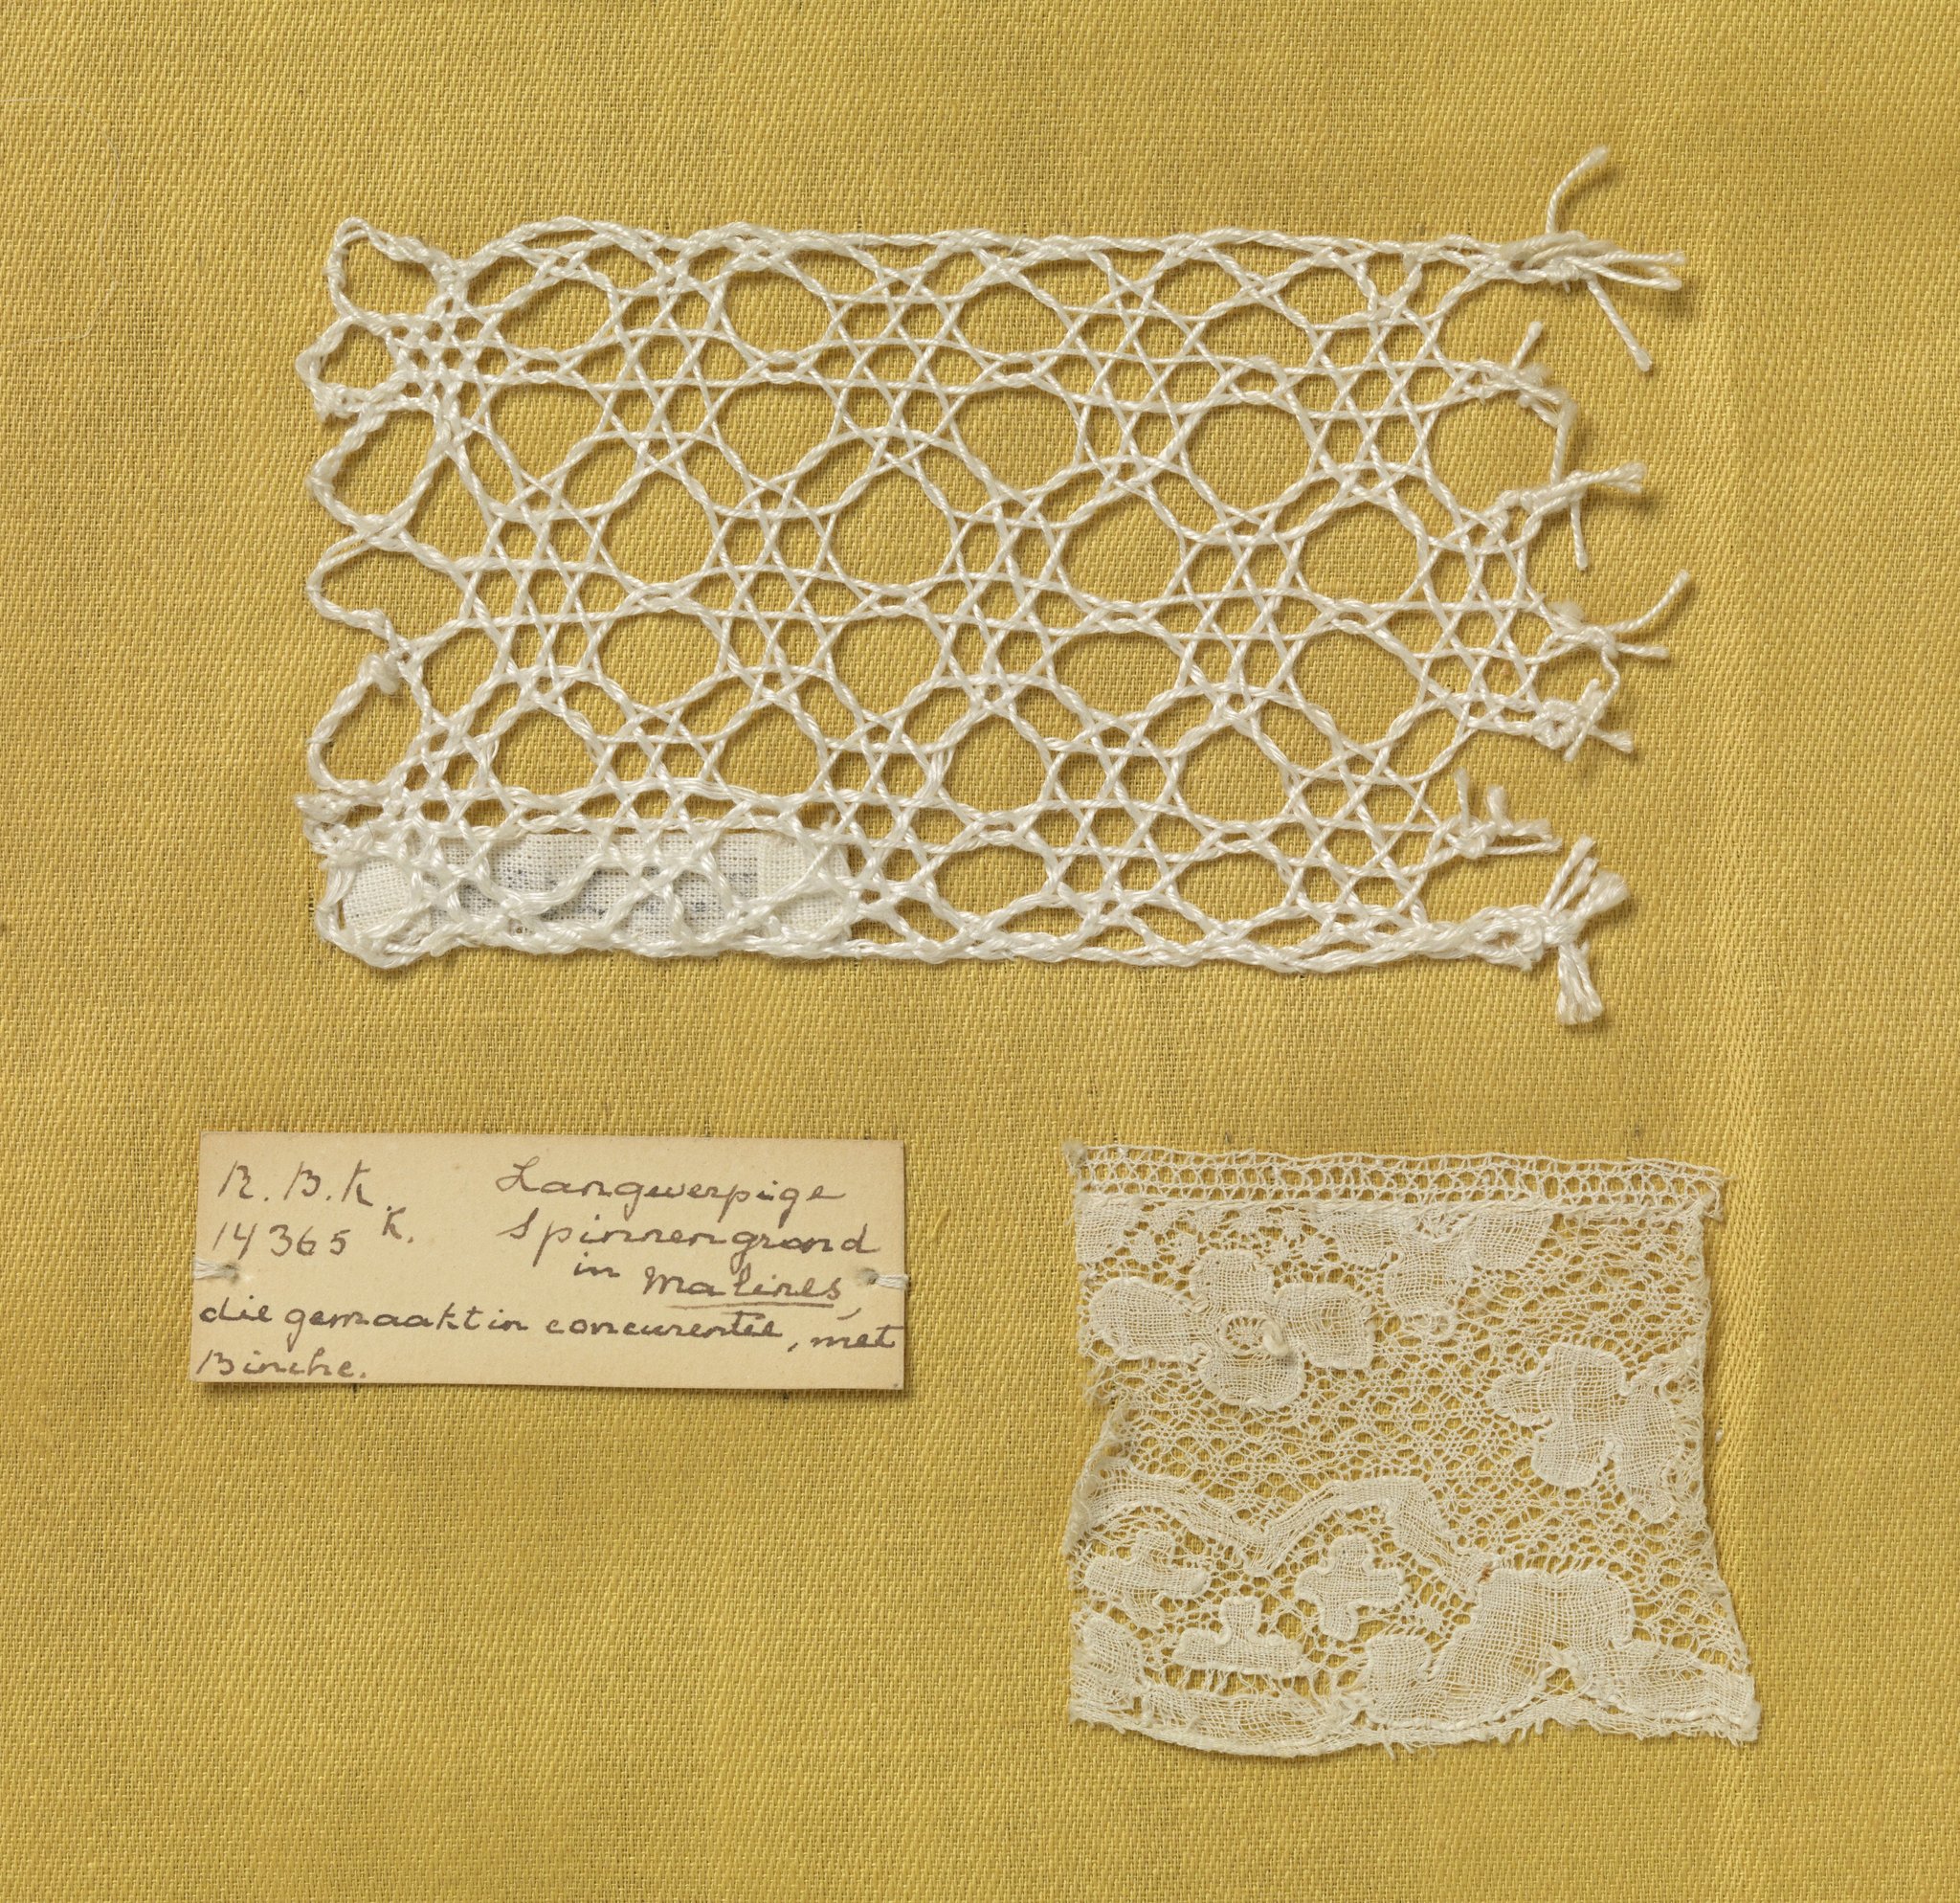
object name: sample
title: Staal kloskant met grove draad als voorbeeld van armure-grond (traliegrond)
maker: Anonymous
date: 1900-1930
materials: cotton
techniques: lace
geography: amsterdam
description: Staal naturelkleurige kloskant met grove draad als voorbeeld van een armure-grond met daarbij een fragment Mechelse kant waarin deze techniek is toegepast. De datering betreft het staal.